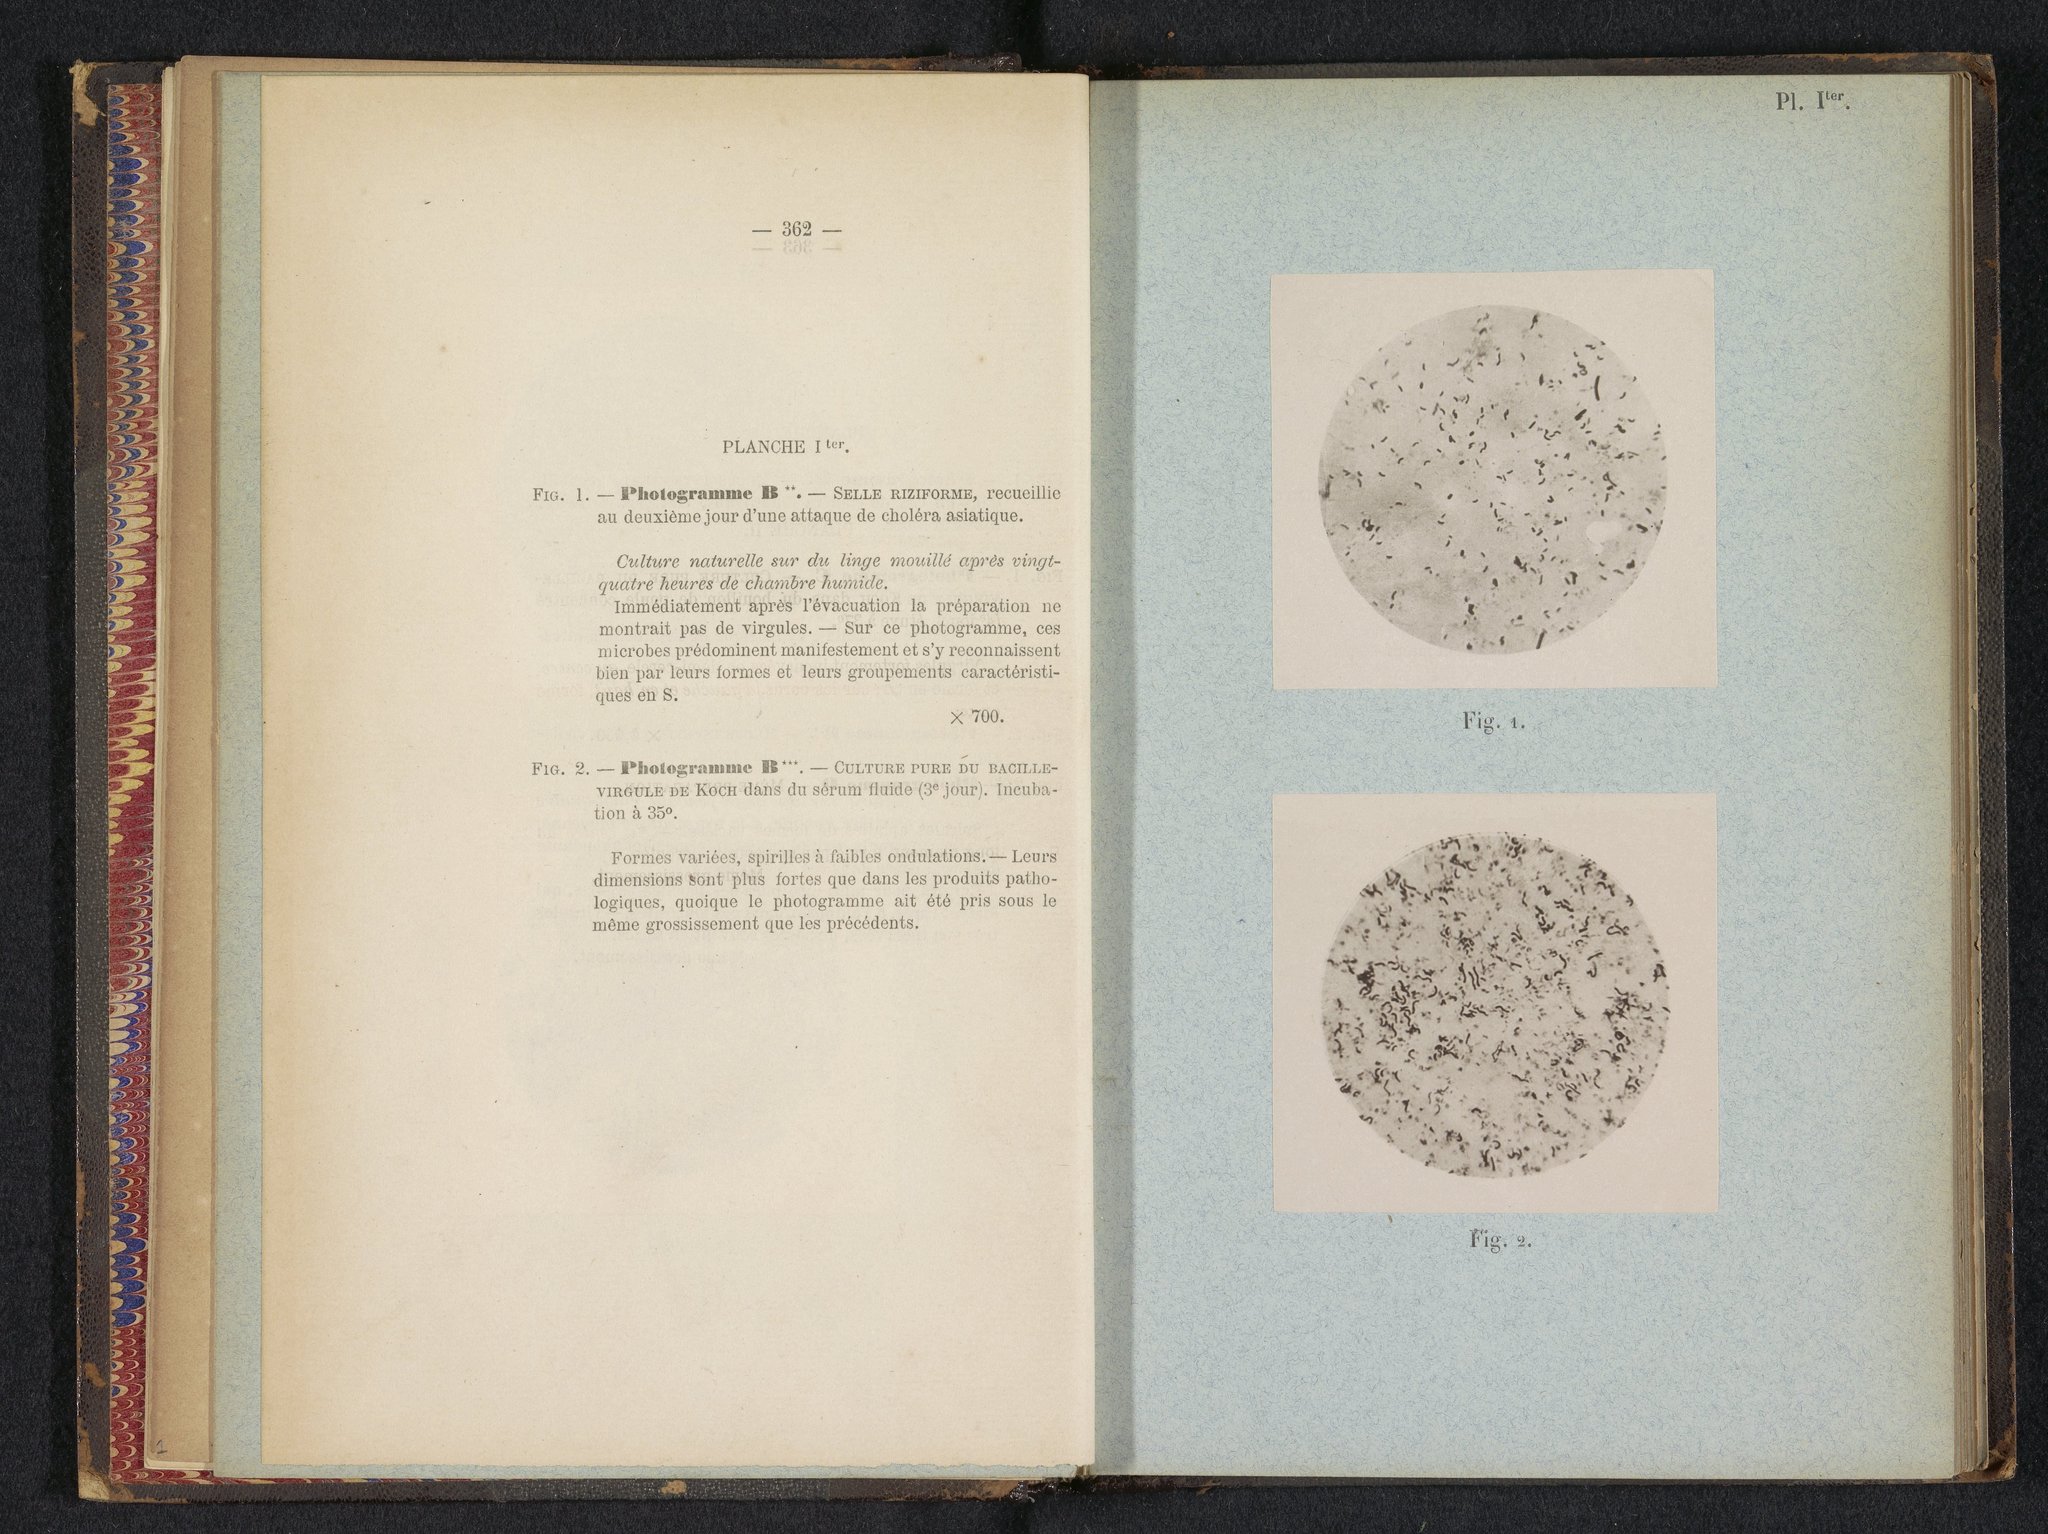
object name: photograph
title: Twee microscoopopnamen van cholera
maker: émile van ermengem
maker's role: bioloog, fotograaf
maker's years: 1851-1932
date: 1875-1885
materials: photographic support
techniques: carbon print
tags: diseases affecting the whole body, microscope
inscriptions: number: ‘Pl. Iter. Fig. 1. Fig. 2.’, inscription: ‘Fig. 1.- Photogramme B**. Selle Riziforme, recueillie aux deuxième jour d'un attaque de choléra asiatique (...) Fig. 2. - Photogramme B***.- Culture pure du bacille-virgule de Koch dans du sérun fluide (3e jour). Incubation à 35° .(...)’